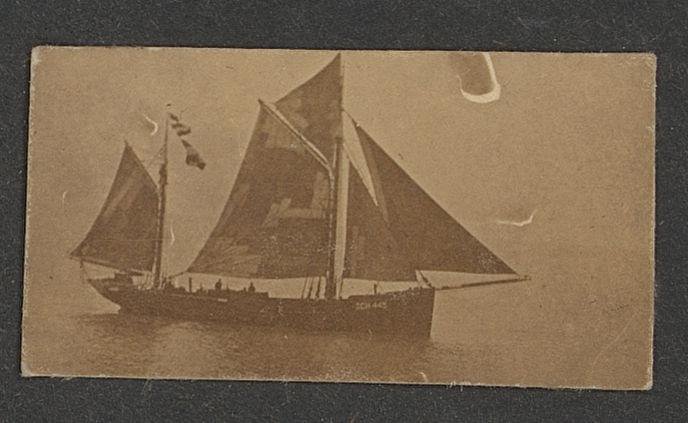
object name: photograph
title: The fisherfleet leaving; relatives send the last goodbye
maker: Anonymous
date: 1920-1925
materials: paper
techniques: gelatin silver print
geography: south holland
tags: sailing-ship, sailing-boat, sea